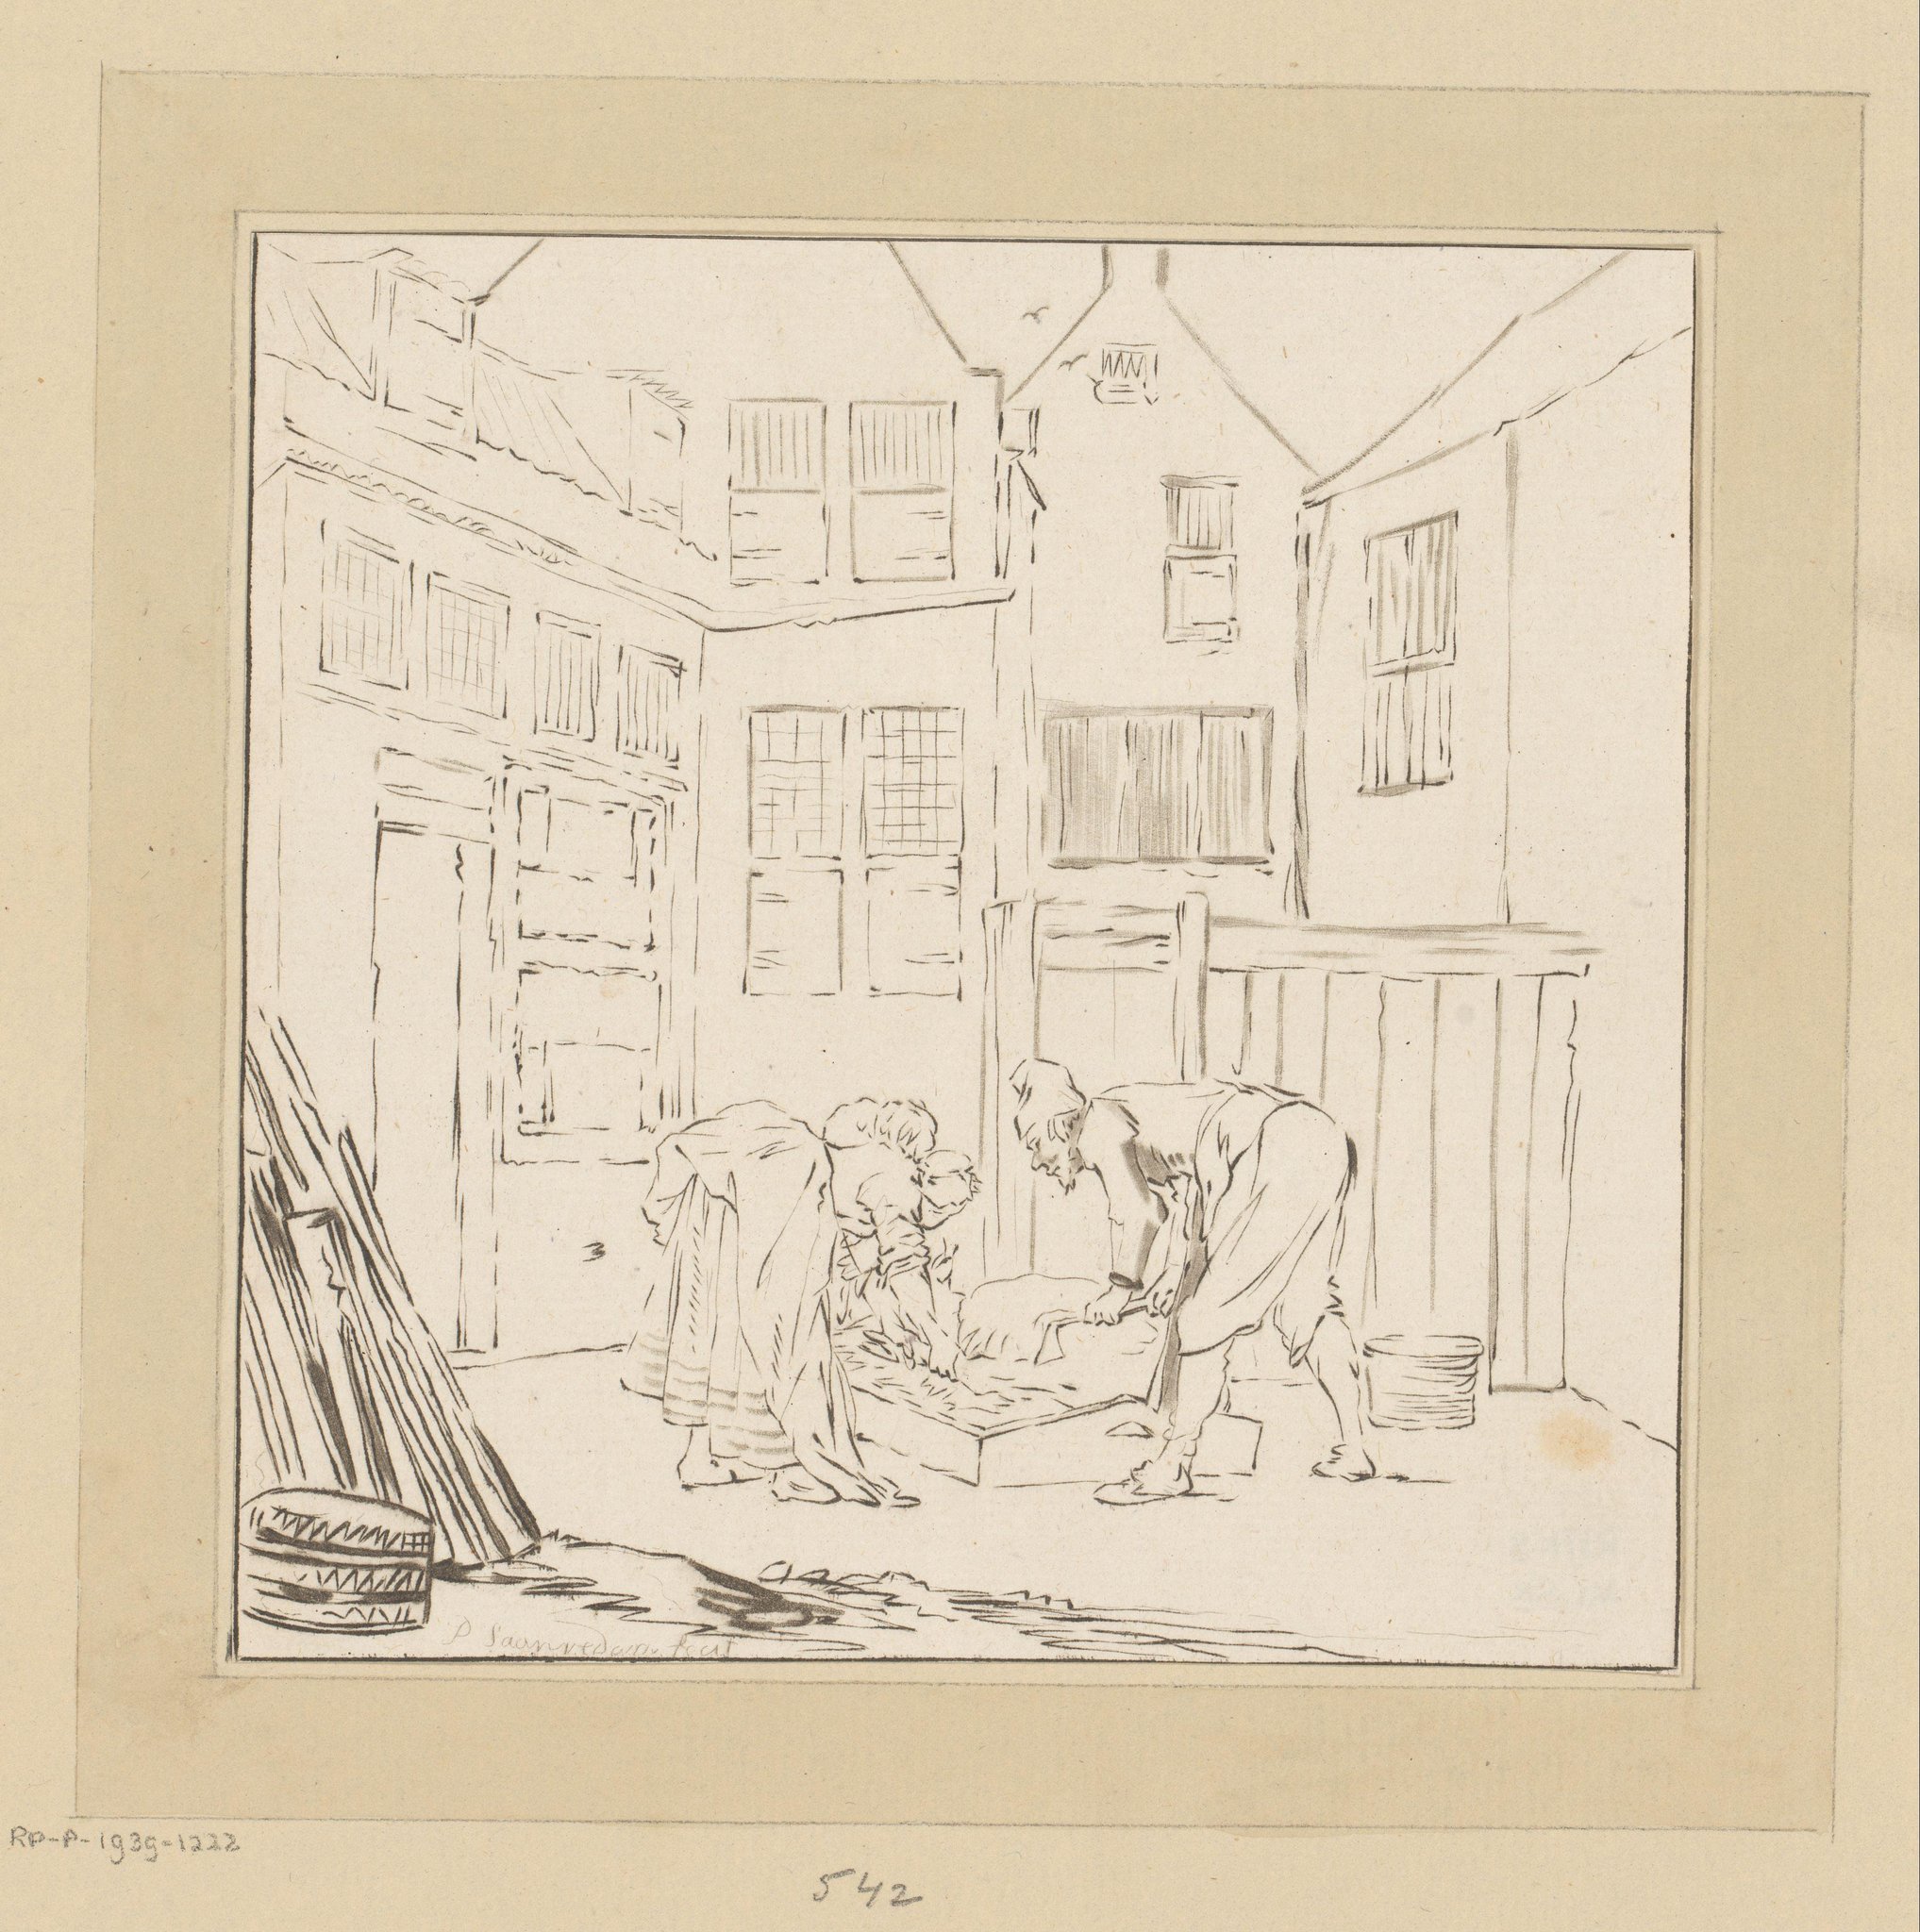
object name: print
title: Varkensslacht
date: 1778-1787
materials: paper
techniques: etching, roulette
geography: amsterdam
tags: slaughtered ox or pig, butcher, slaughterman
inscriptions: collector's mark: ‘RIJKS / MUSM’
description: Op een binnenplaats slachten een man en een vrouw een varken. De prent ligt los in een album, zie blad 41.